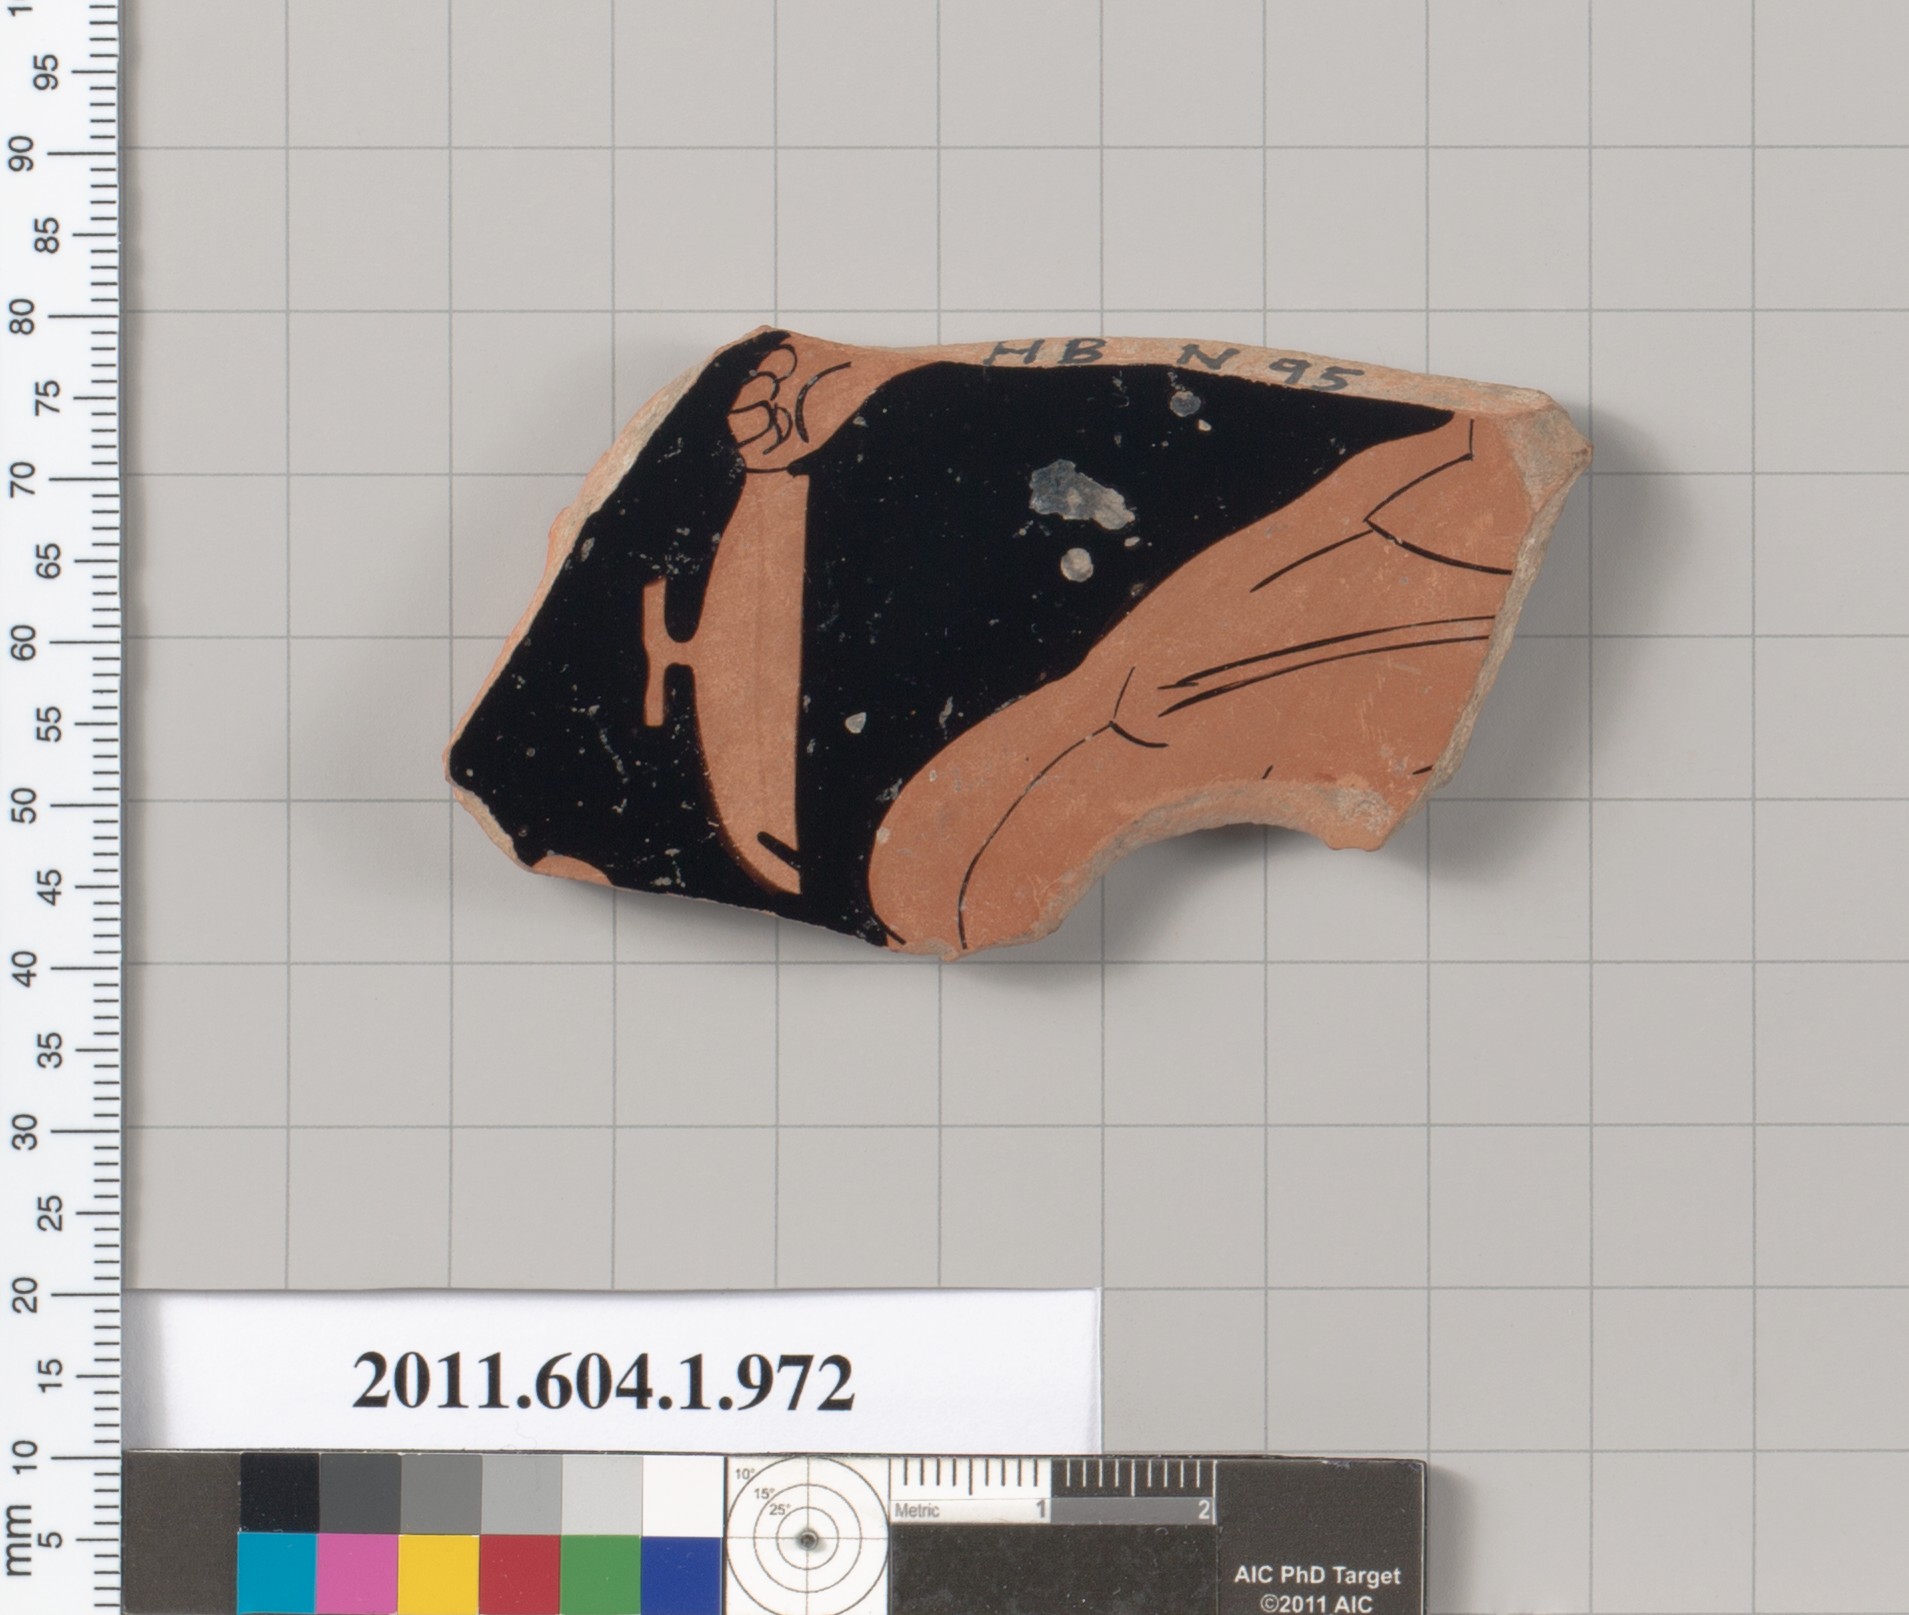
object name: kylix fragment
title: Terracotta fragment of a kylix (drinking cup)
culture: greek, attic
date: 490-480 BCE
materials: terracotta